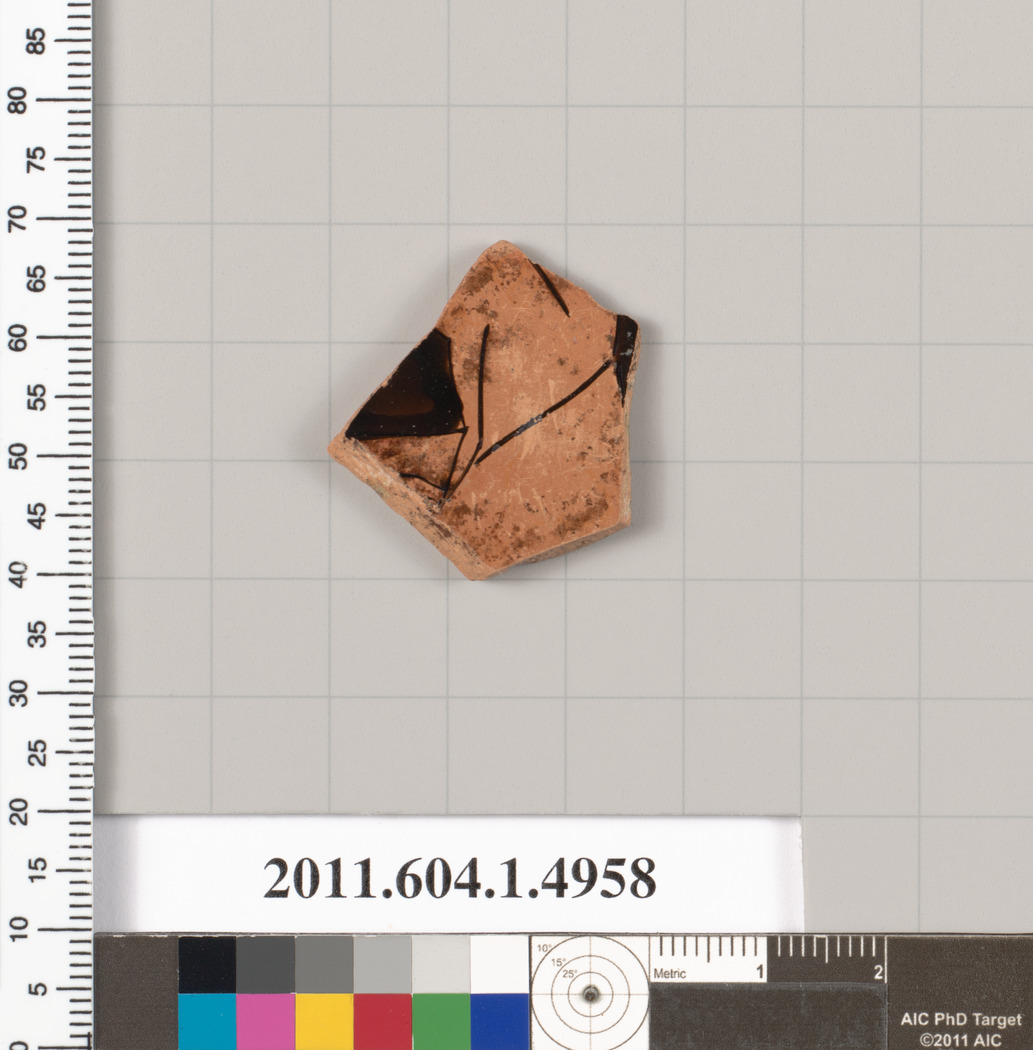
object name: kylix fragment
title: Terracotta fragment of a kylix (drinking cup)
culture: greek, attic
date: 510-490 BCE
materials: terracotta